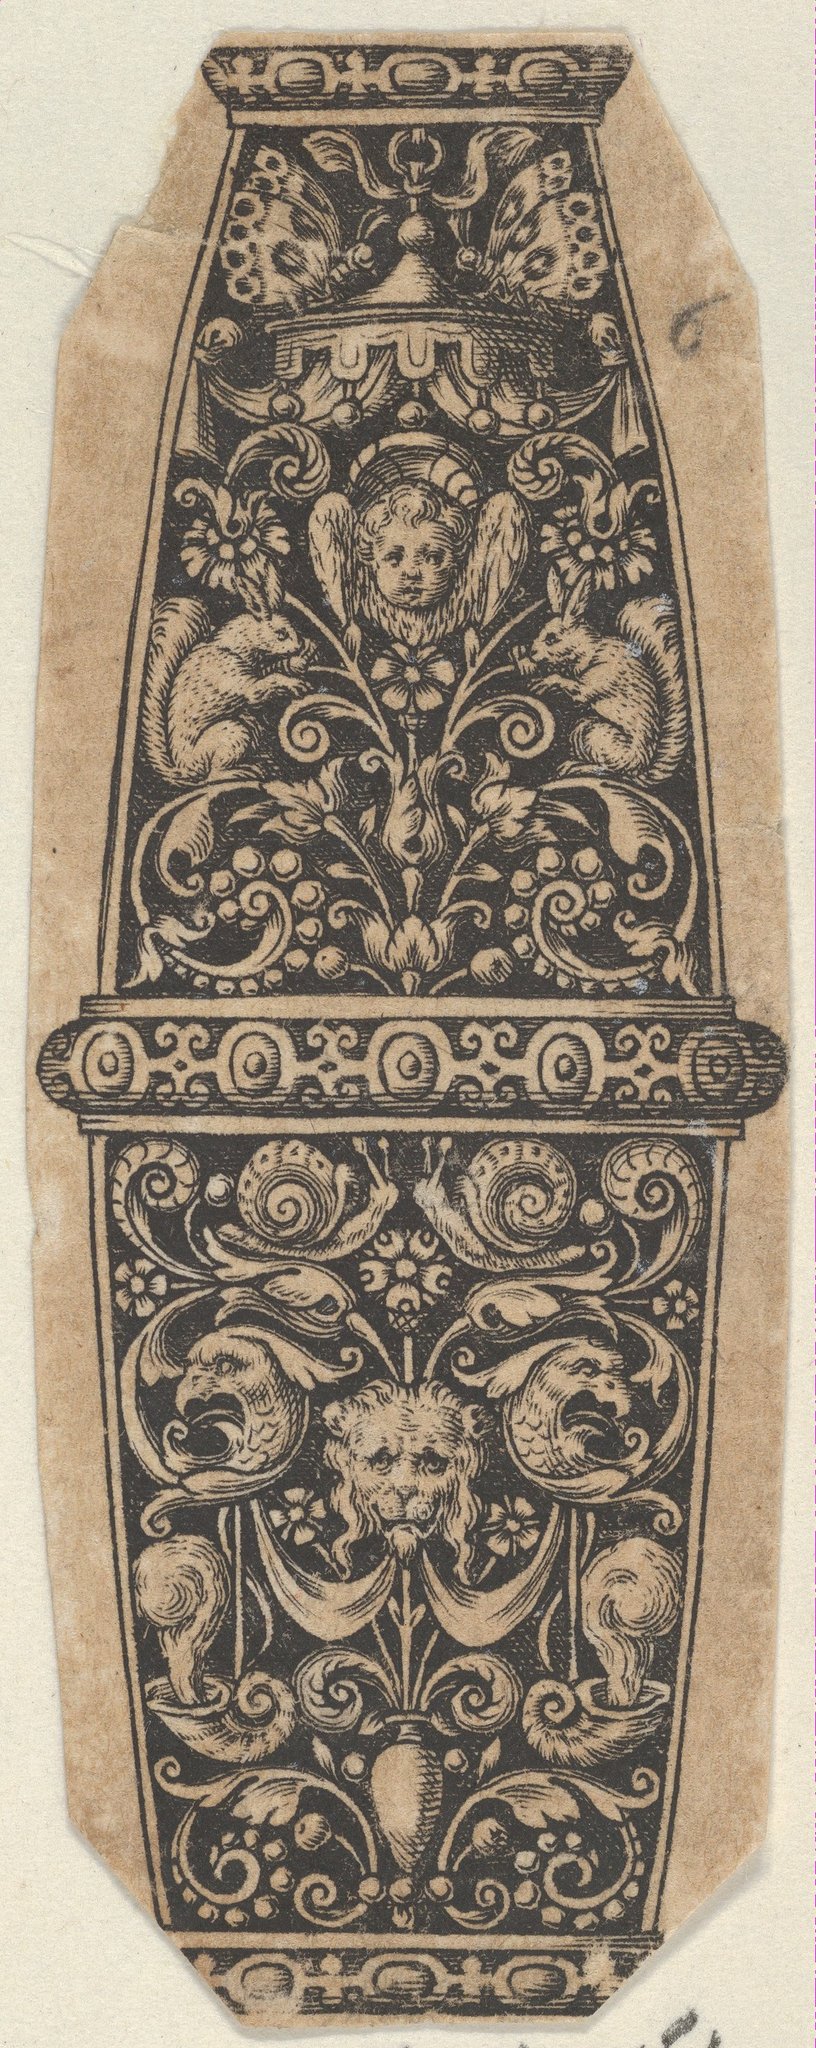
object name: print ornament architecture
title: Design for a Sword or Dagger Handle with Putto-Head and Lion's-Head Masks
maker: theodor de bry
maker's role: artist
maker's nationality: netherlandish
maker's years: 1528-1598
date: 1592-1593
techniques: embroidery, engraving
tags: hilts,mythical creatures,butterflies,snails